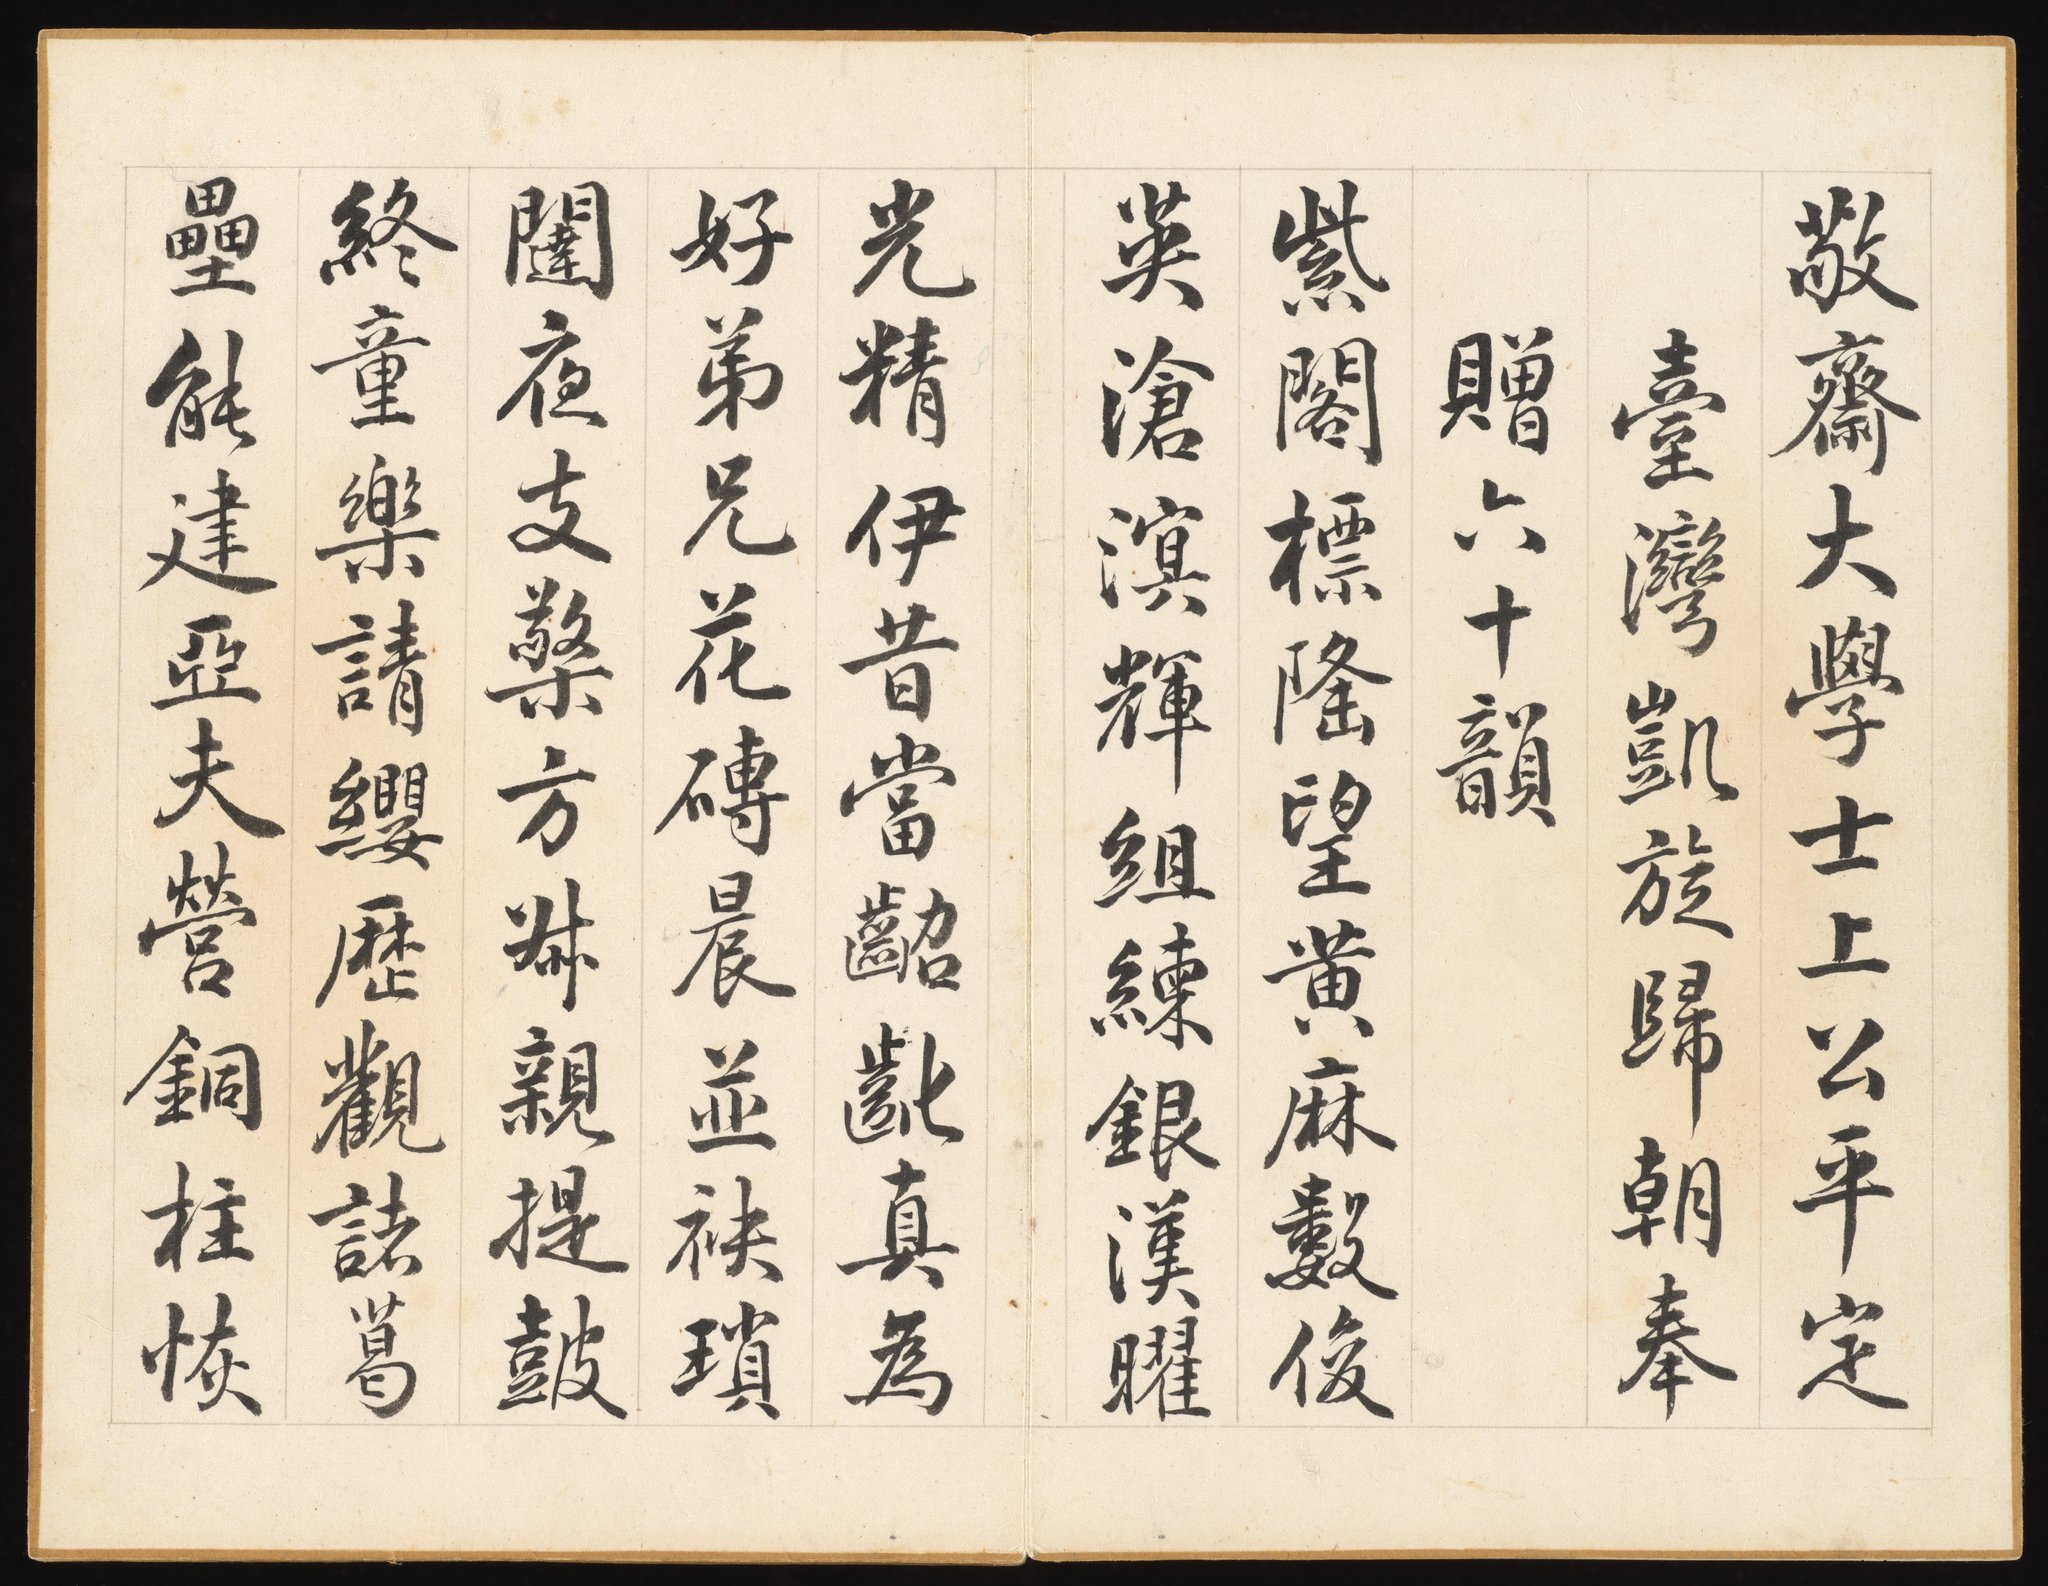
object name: album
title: Poems for Jingzhai Presented upon his Triumphant Return from Pacifying Taiwan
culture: chinese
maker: hongwu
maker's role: artist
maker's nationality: chinese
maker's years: 1743-1811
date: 1788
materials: ink, paper